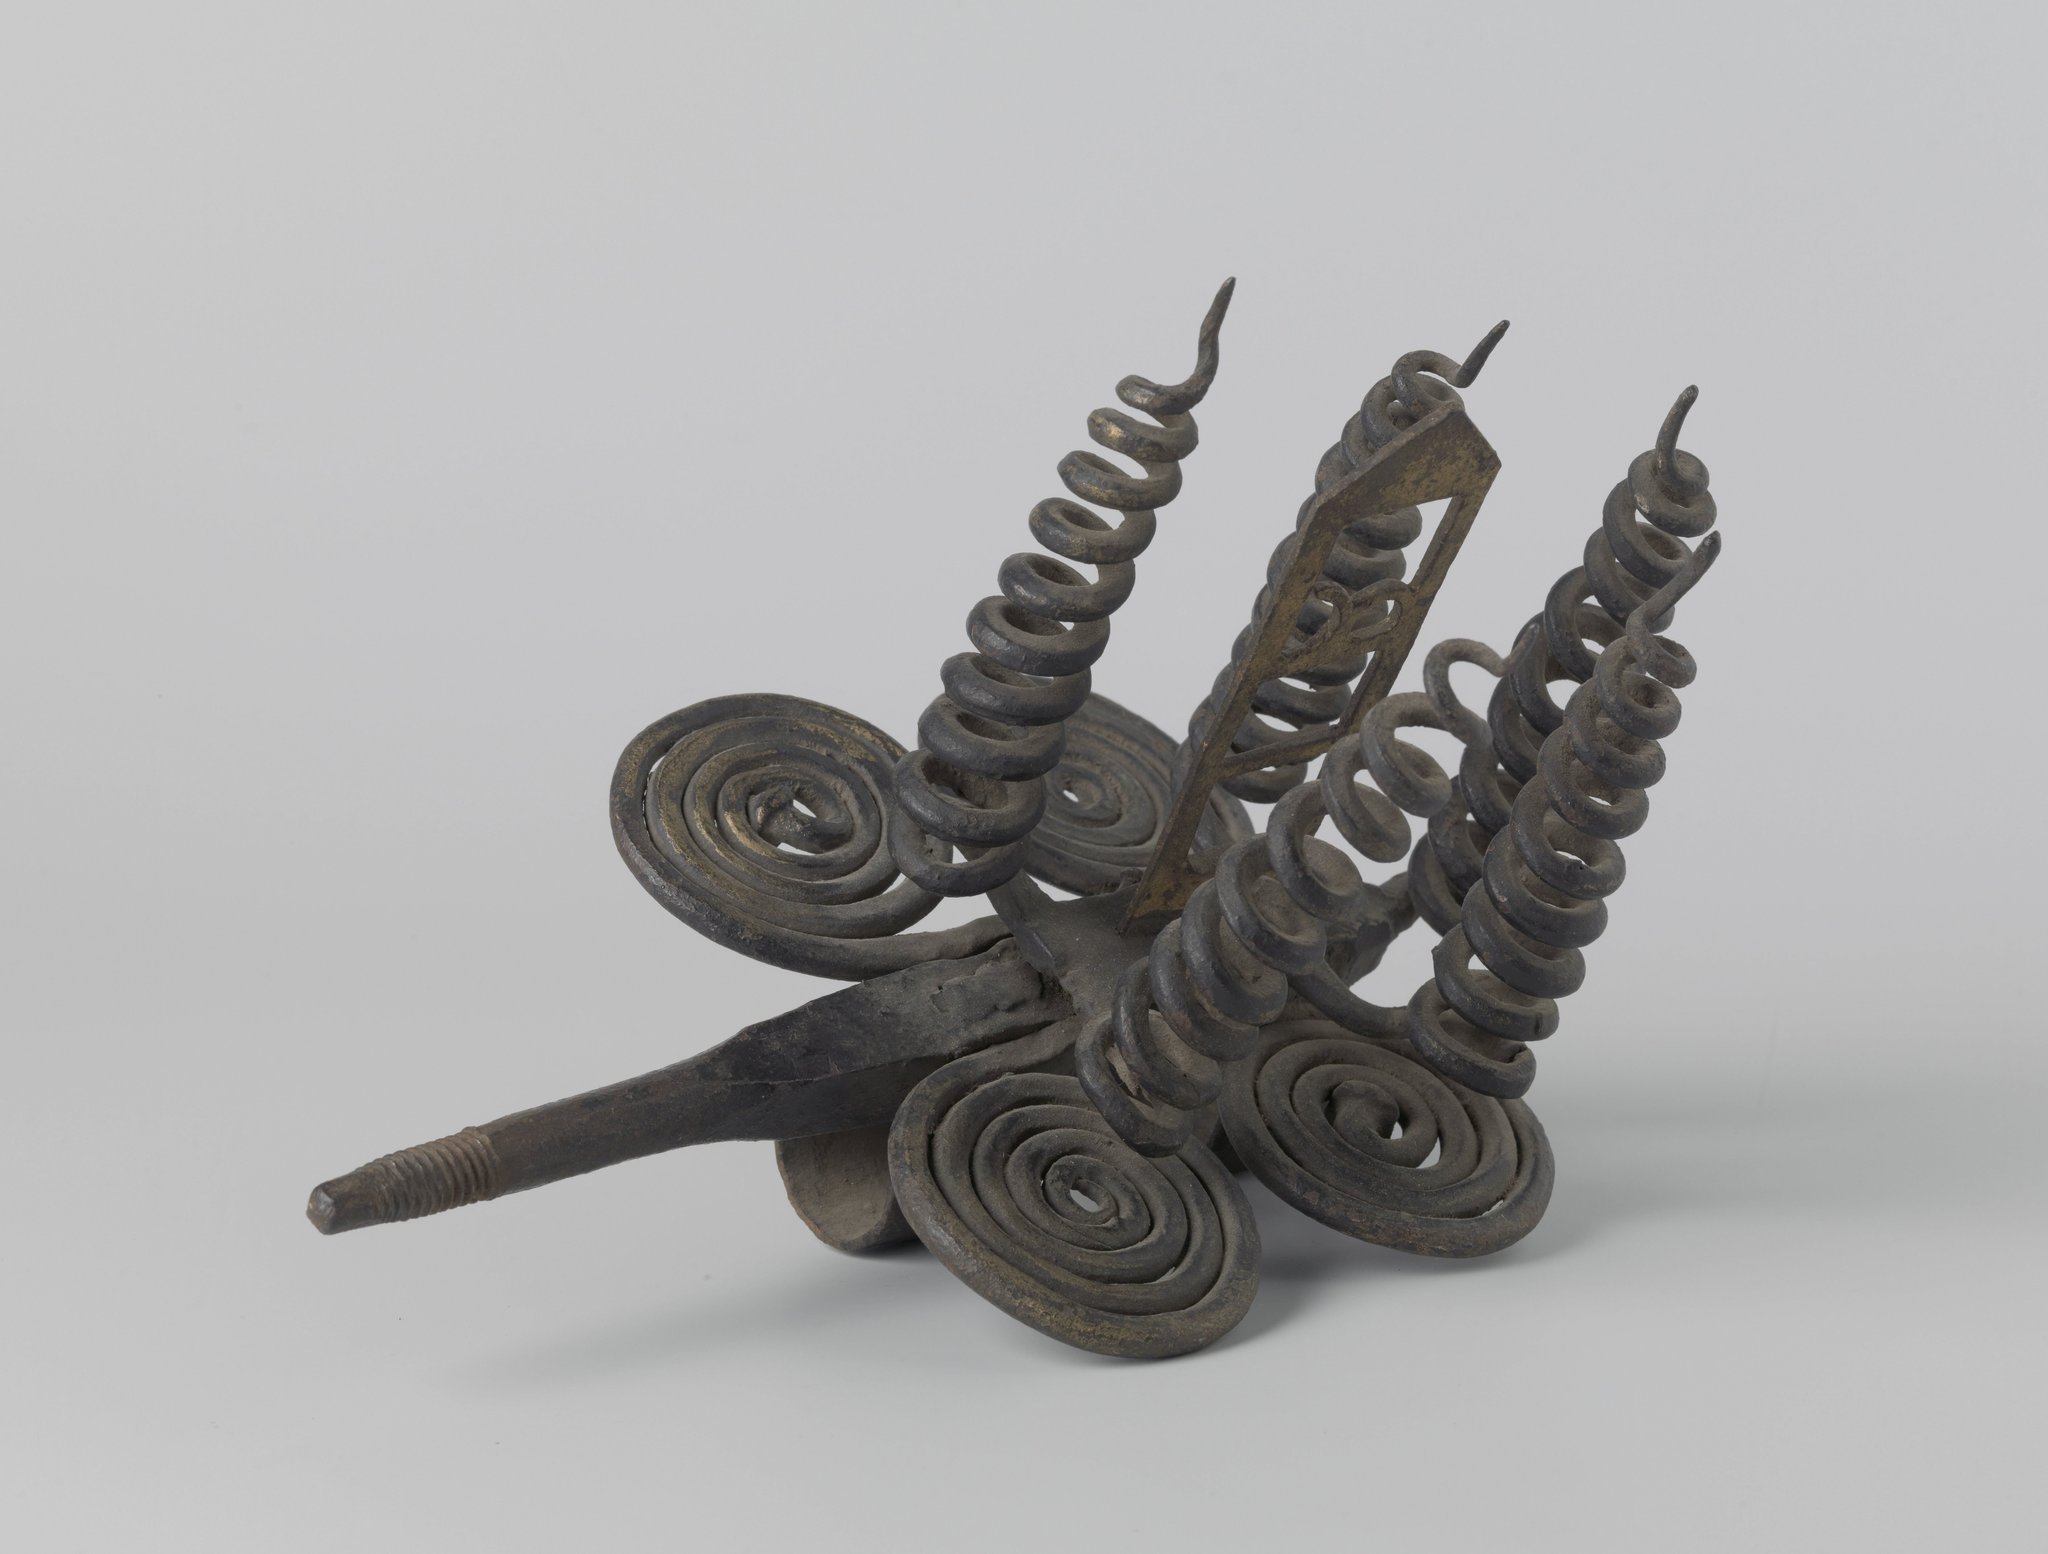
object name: flagpole holder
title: Vlaggenstokhouder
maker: Anonymous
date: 1850-1900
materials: metal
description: Vlaggenstokhouder, versierd met vijf spiralen, vier krullen en een metalen plaatje waarin de letters 'IR' zijn uitgezaagd. Met twee aangeklonken ringen, waarin de vlaggenstok gestoken kan worden. Onderzijde loopt uit in ene punt van schroefdraad. Sporen van goudverf. Genummerd '56'.